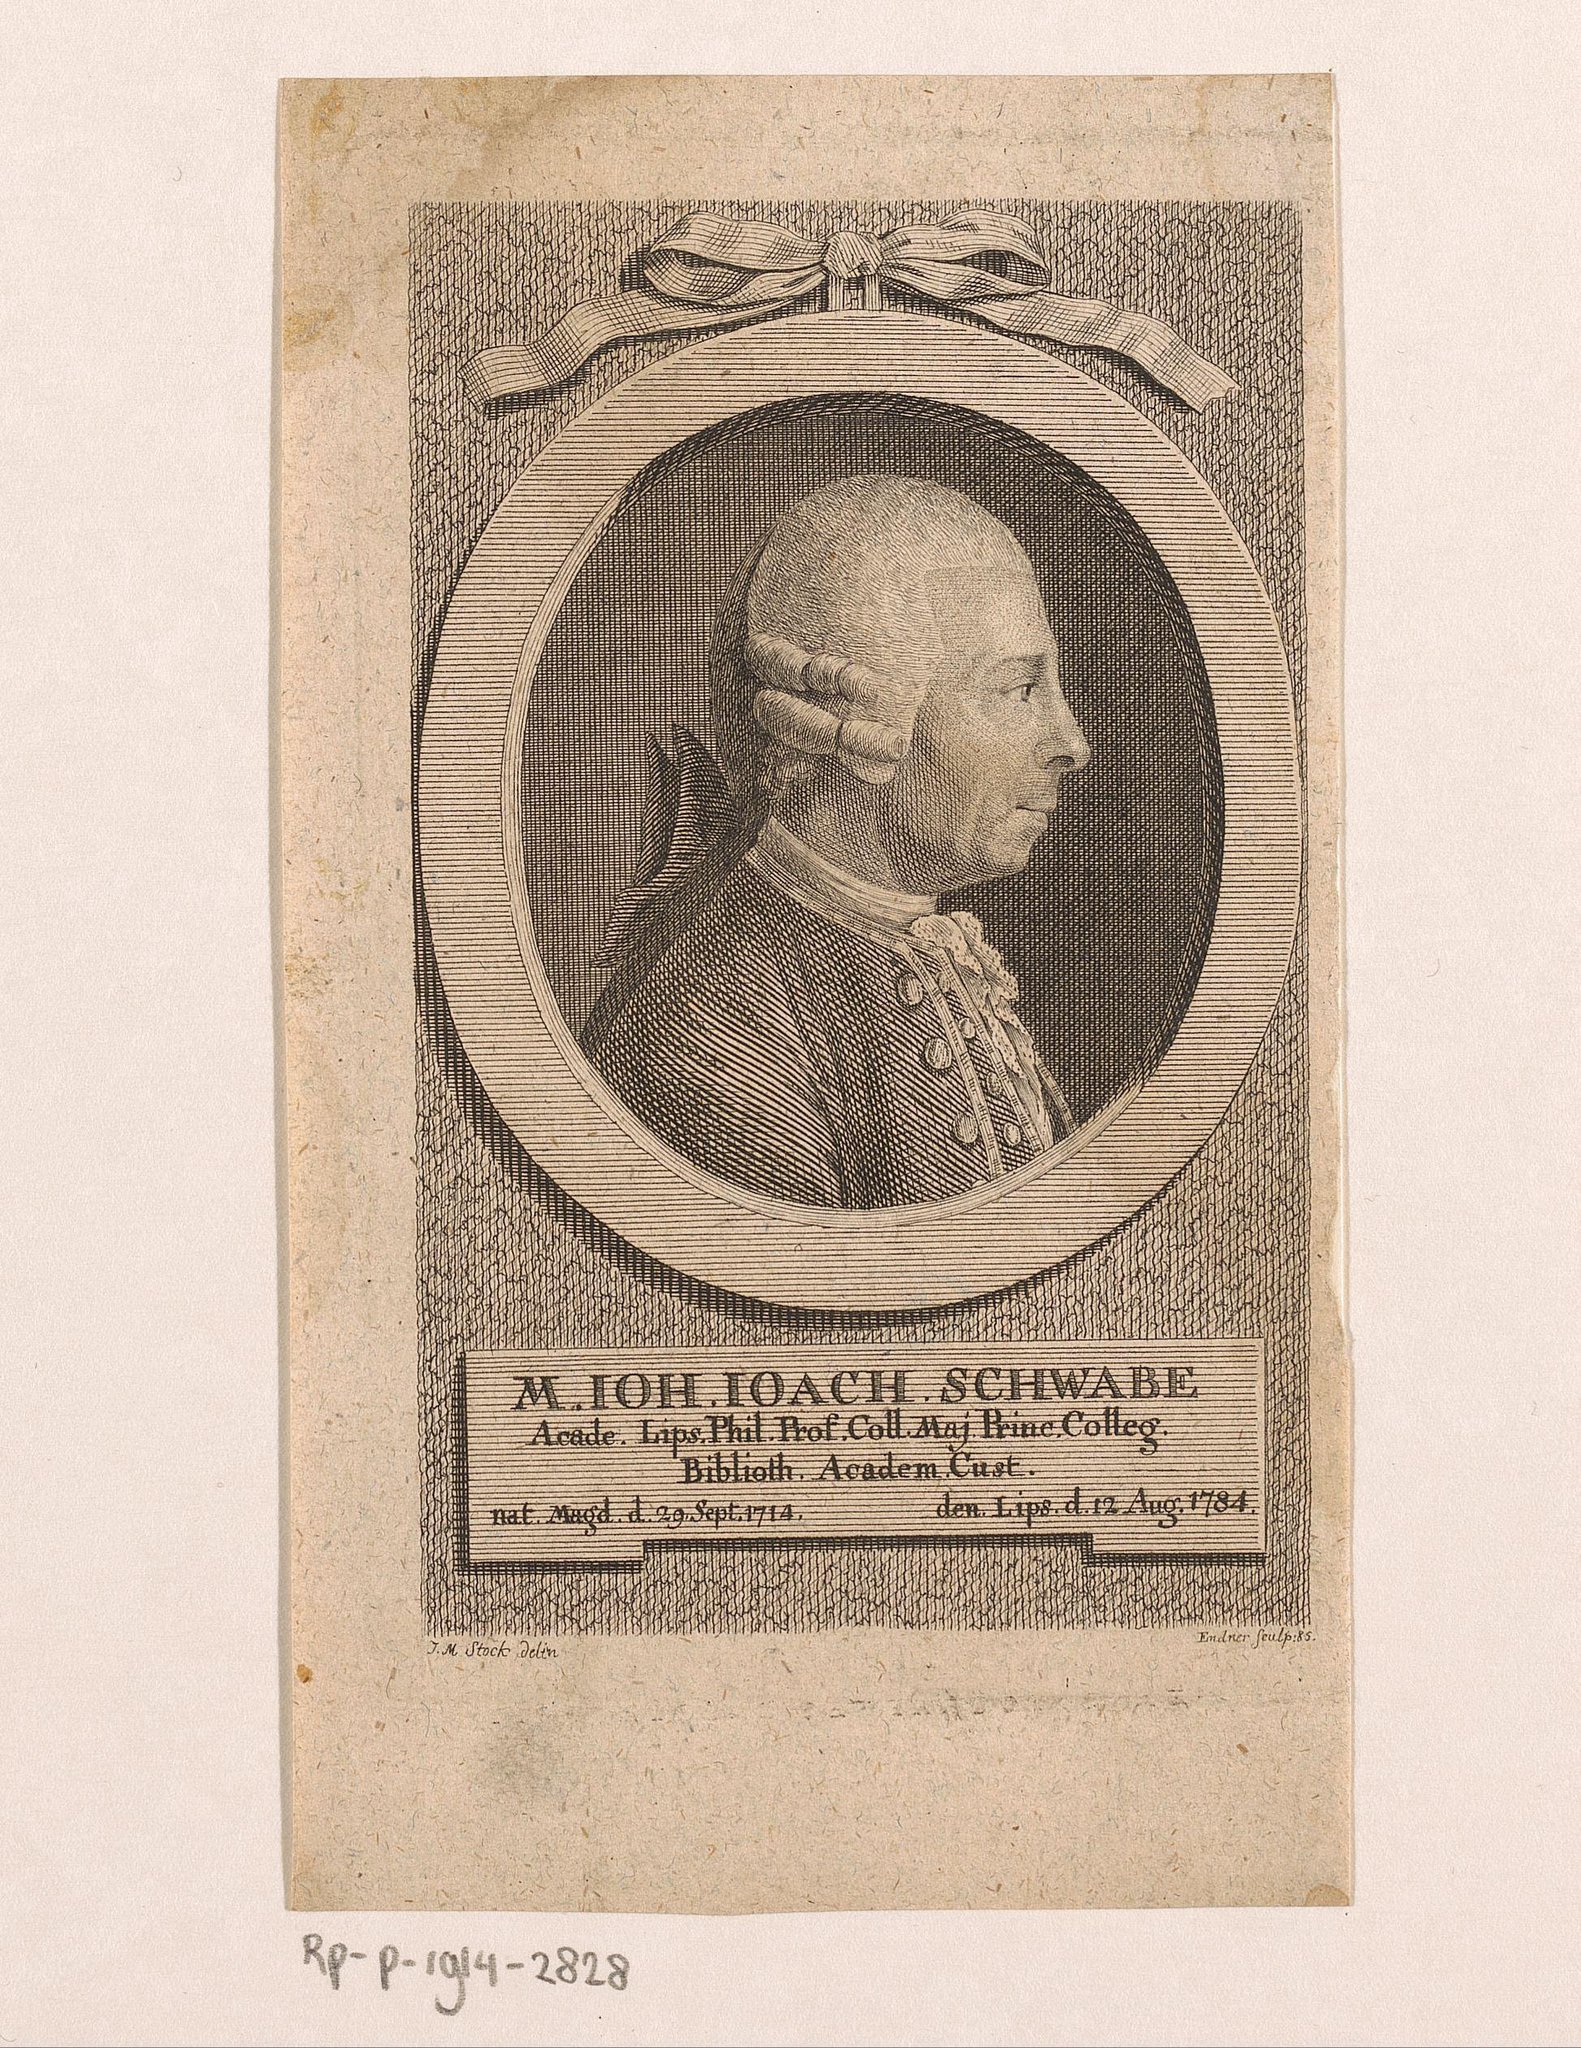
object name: print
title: Portret van Johann Joachim Schwabe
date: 1785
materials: paper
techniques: engraving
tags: ornament ~ medallion, historical persons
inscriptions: collector's mark: Lugt 2228